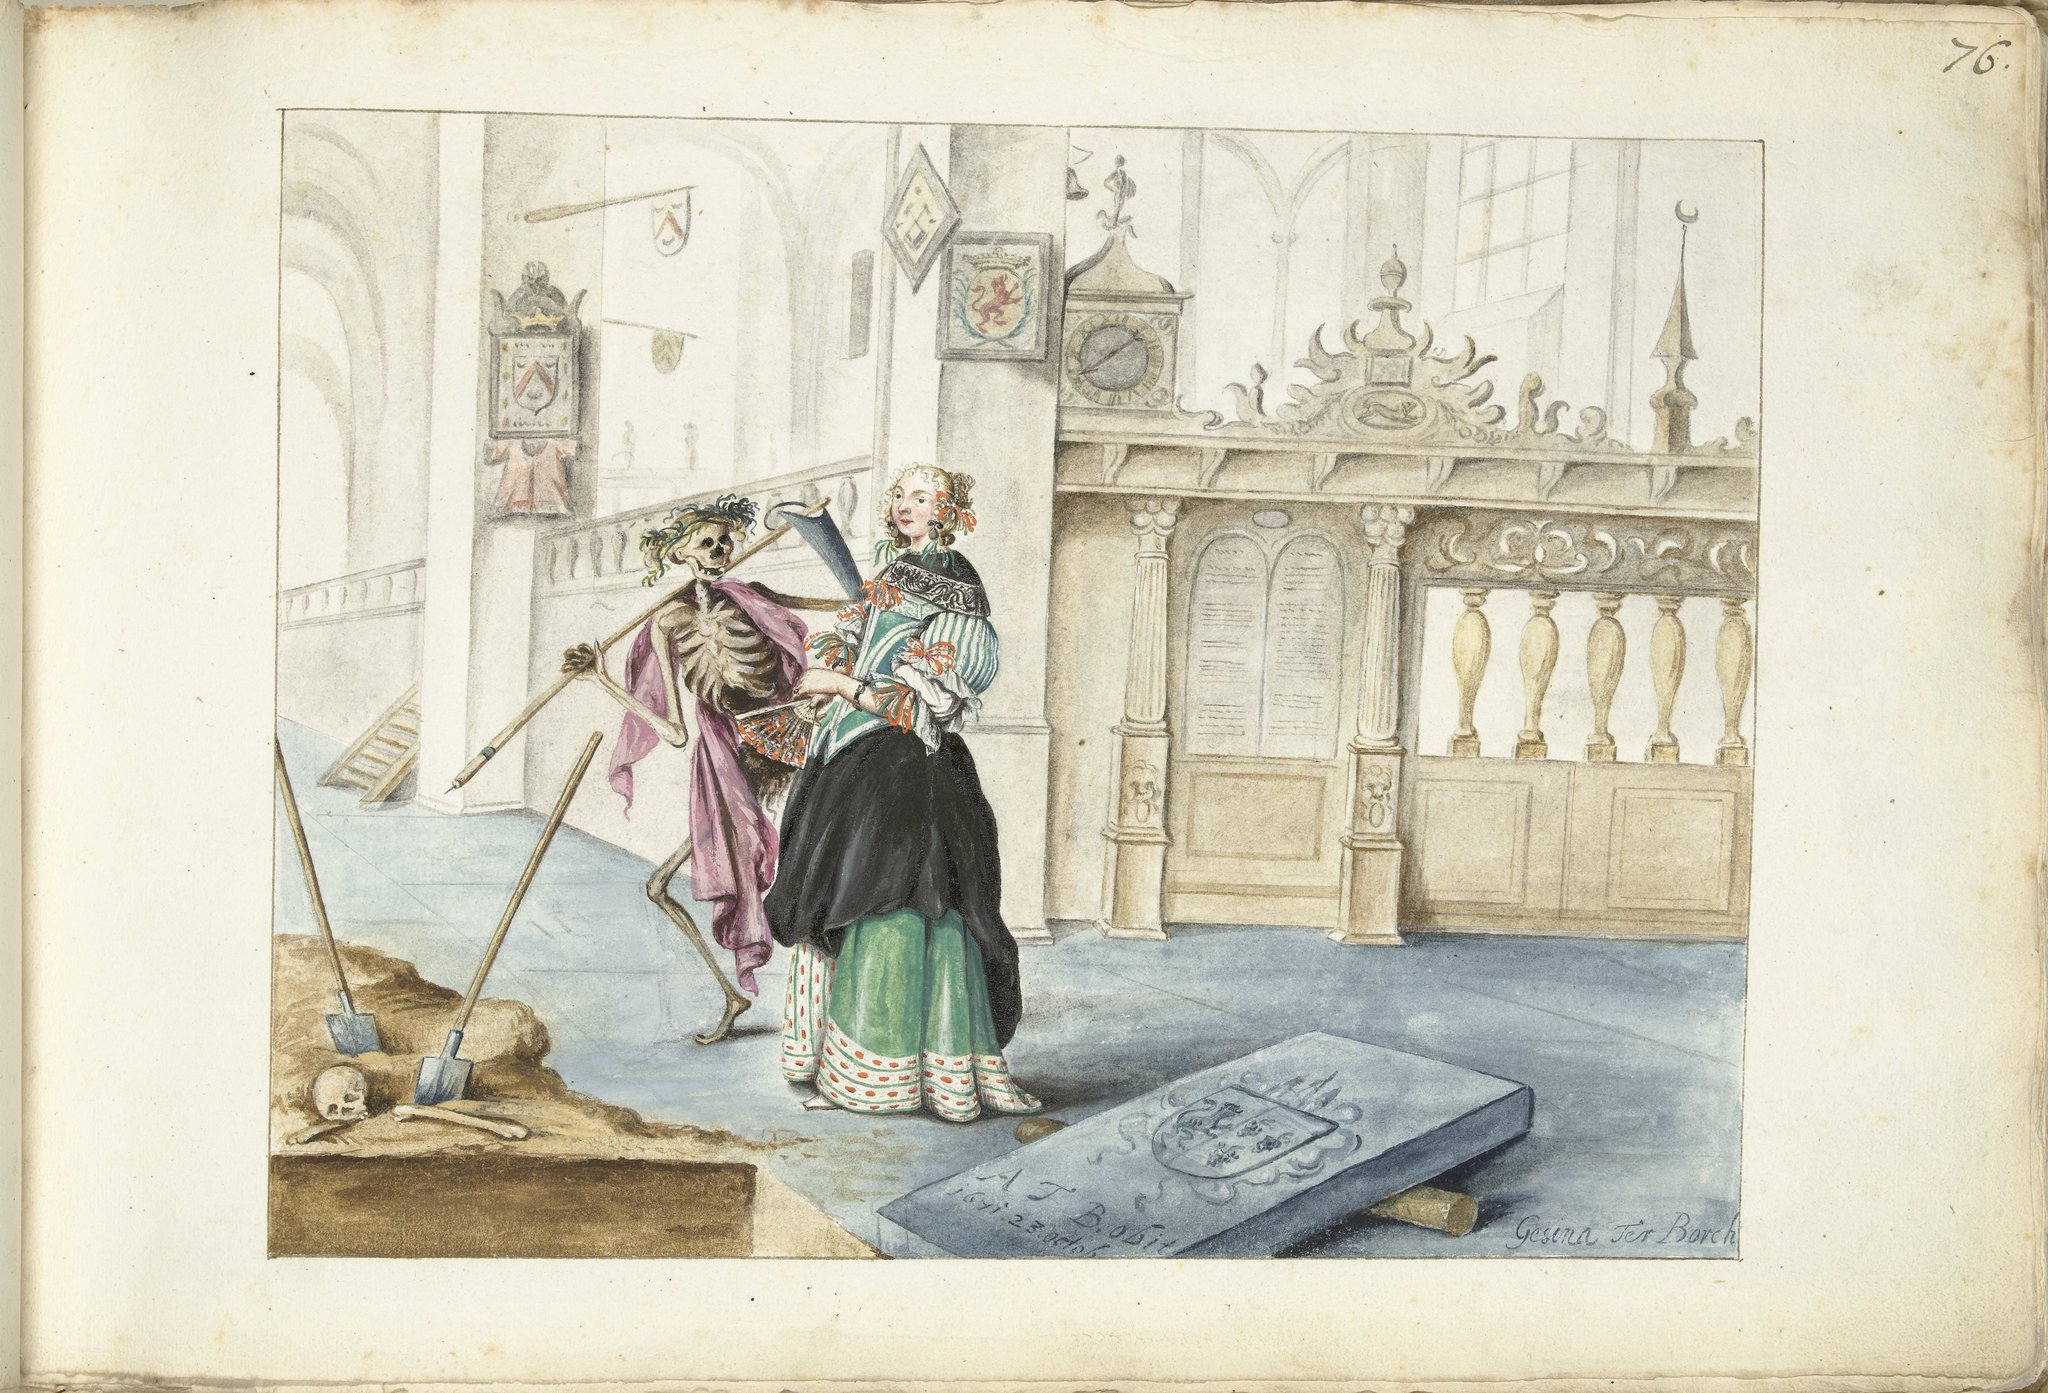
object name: drawing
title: Vrouw (Aeltien?) staand naast de Dood in de Sint-Michaëlskerk, Zwolle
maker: gesina ter borch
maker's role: draughtsman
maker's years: 1633-1690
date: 1671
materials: chalk, paper, watercolor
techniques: brush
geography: zwolle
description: Vrouw staand in het koor van de Sint-Michaëlskerk te Zwolle, mogelijk Gesina's zus Aleida of Aeltien ter Borch. Op de voorgrond is een open graf te zien naast een grafsteen met de wapens van de families Ter Borchs en Condewijn. Op de grafsteen staat: A.T B.obit, 1671.23 octob.